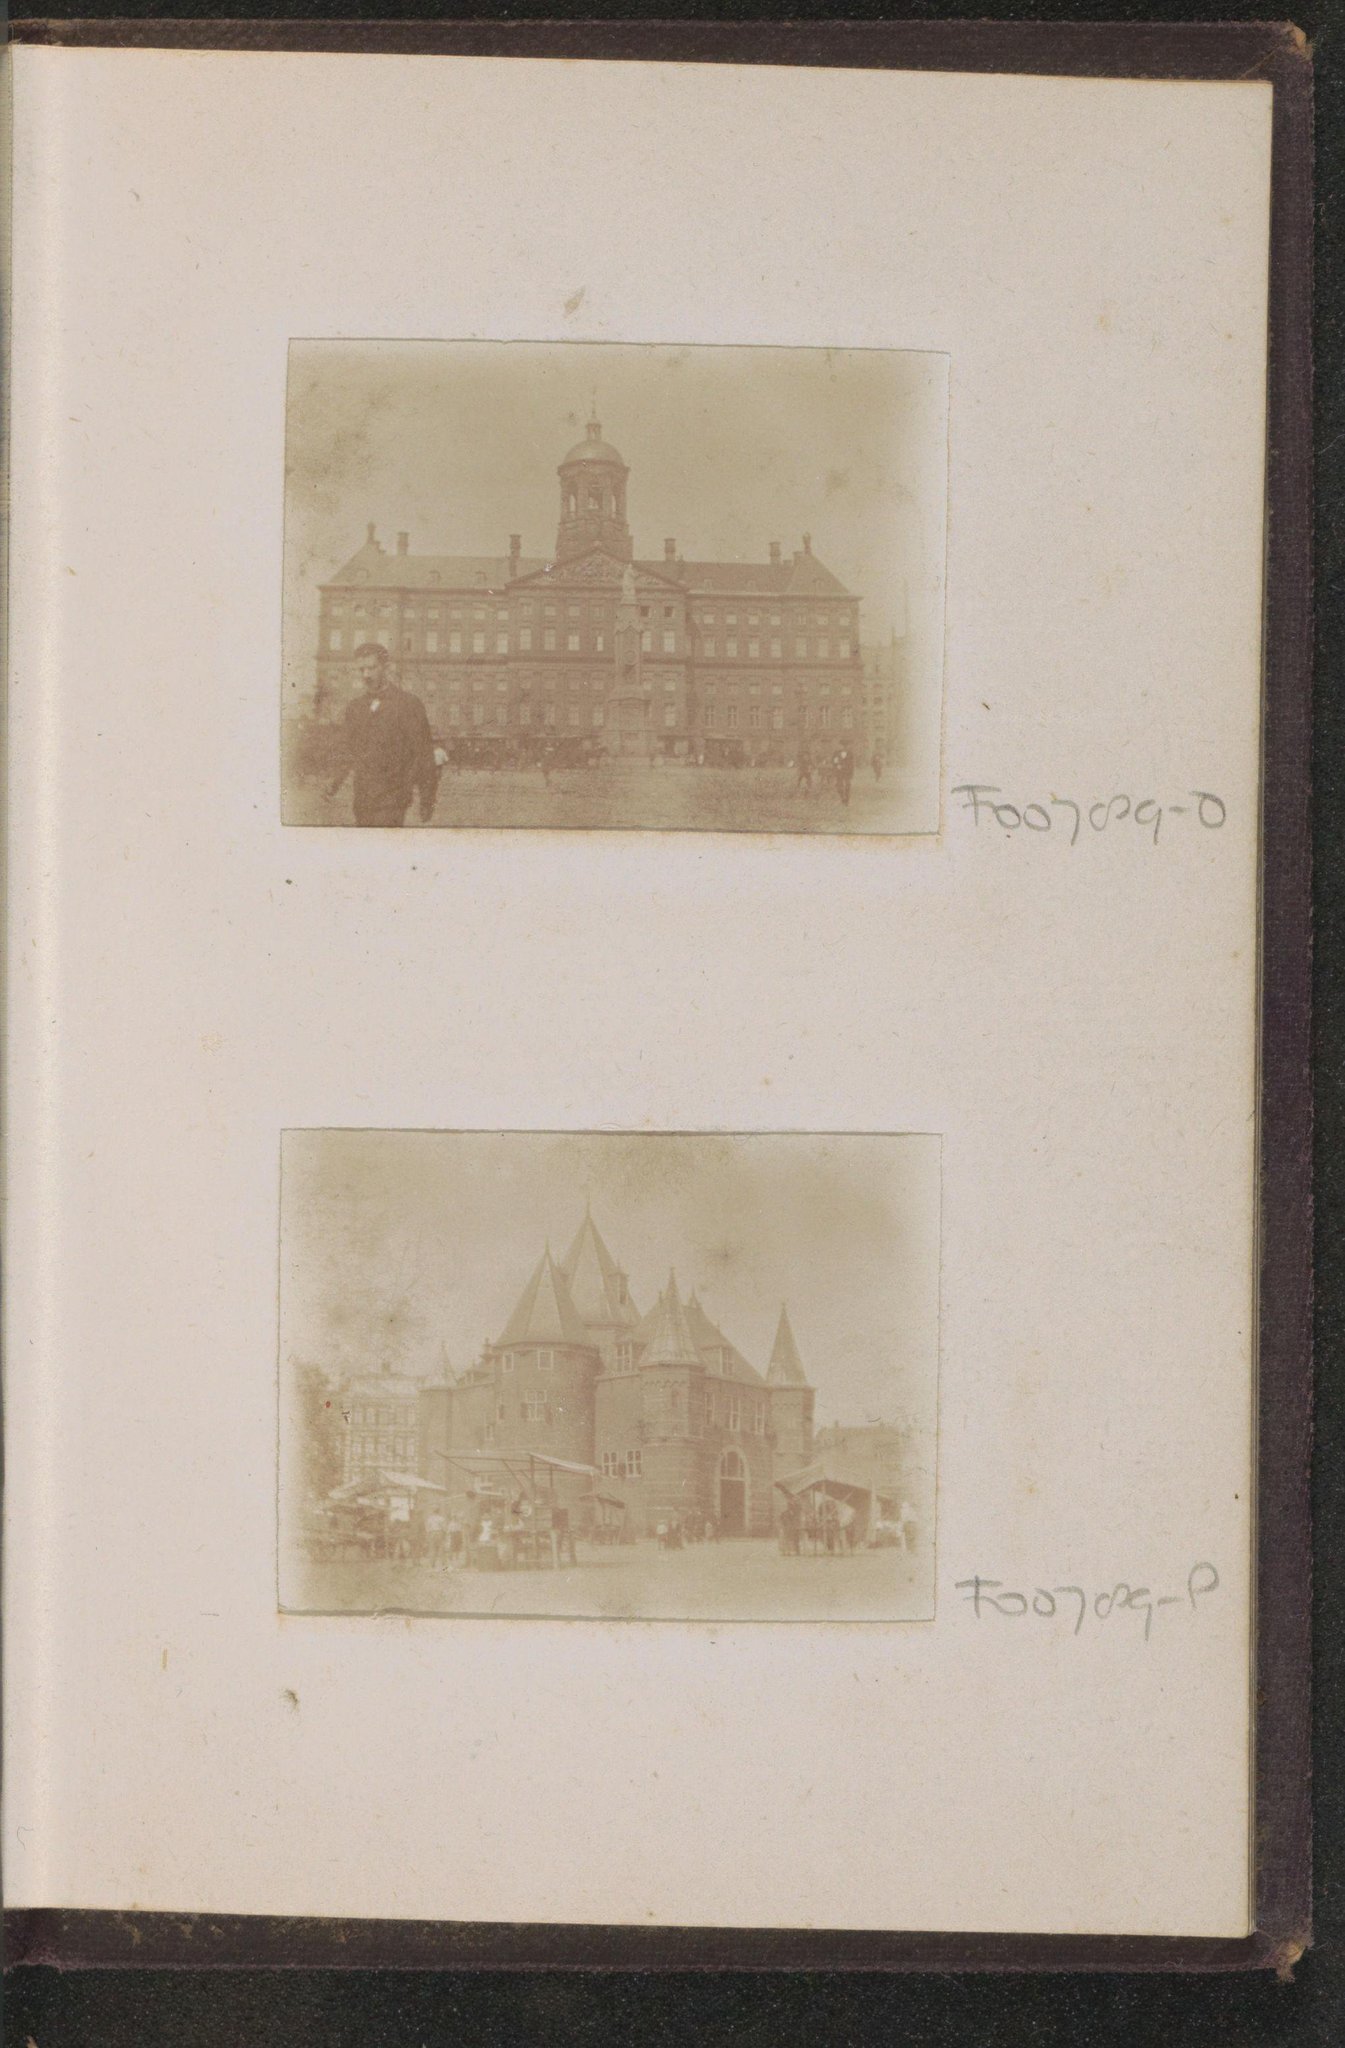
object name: photograph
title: Koninklijk Paleis op de Dam met op de voorgrond een man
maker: Anonymous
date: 1880-1900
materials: paper, photographic support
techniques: collodion silver print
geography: dam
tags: palace, royal palace of amsterdam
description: Onderdeel van Fotoalbum met 35 foto's van Amsterdam, personen en dieren.